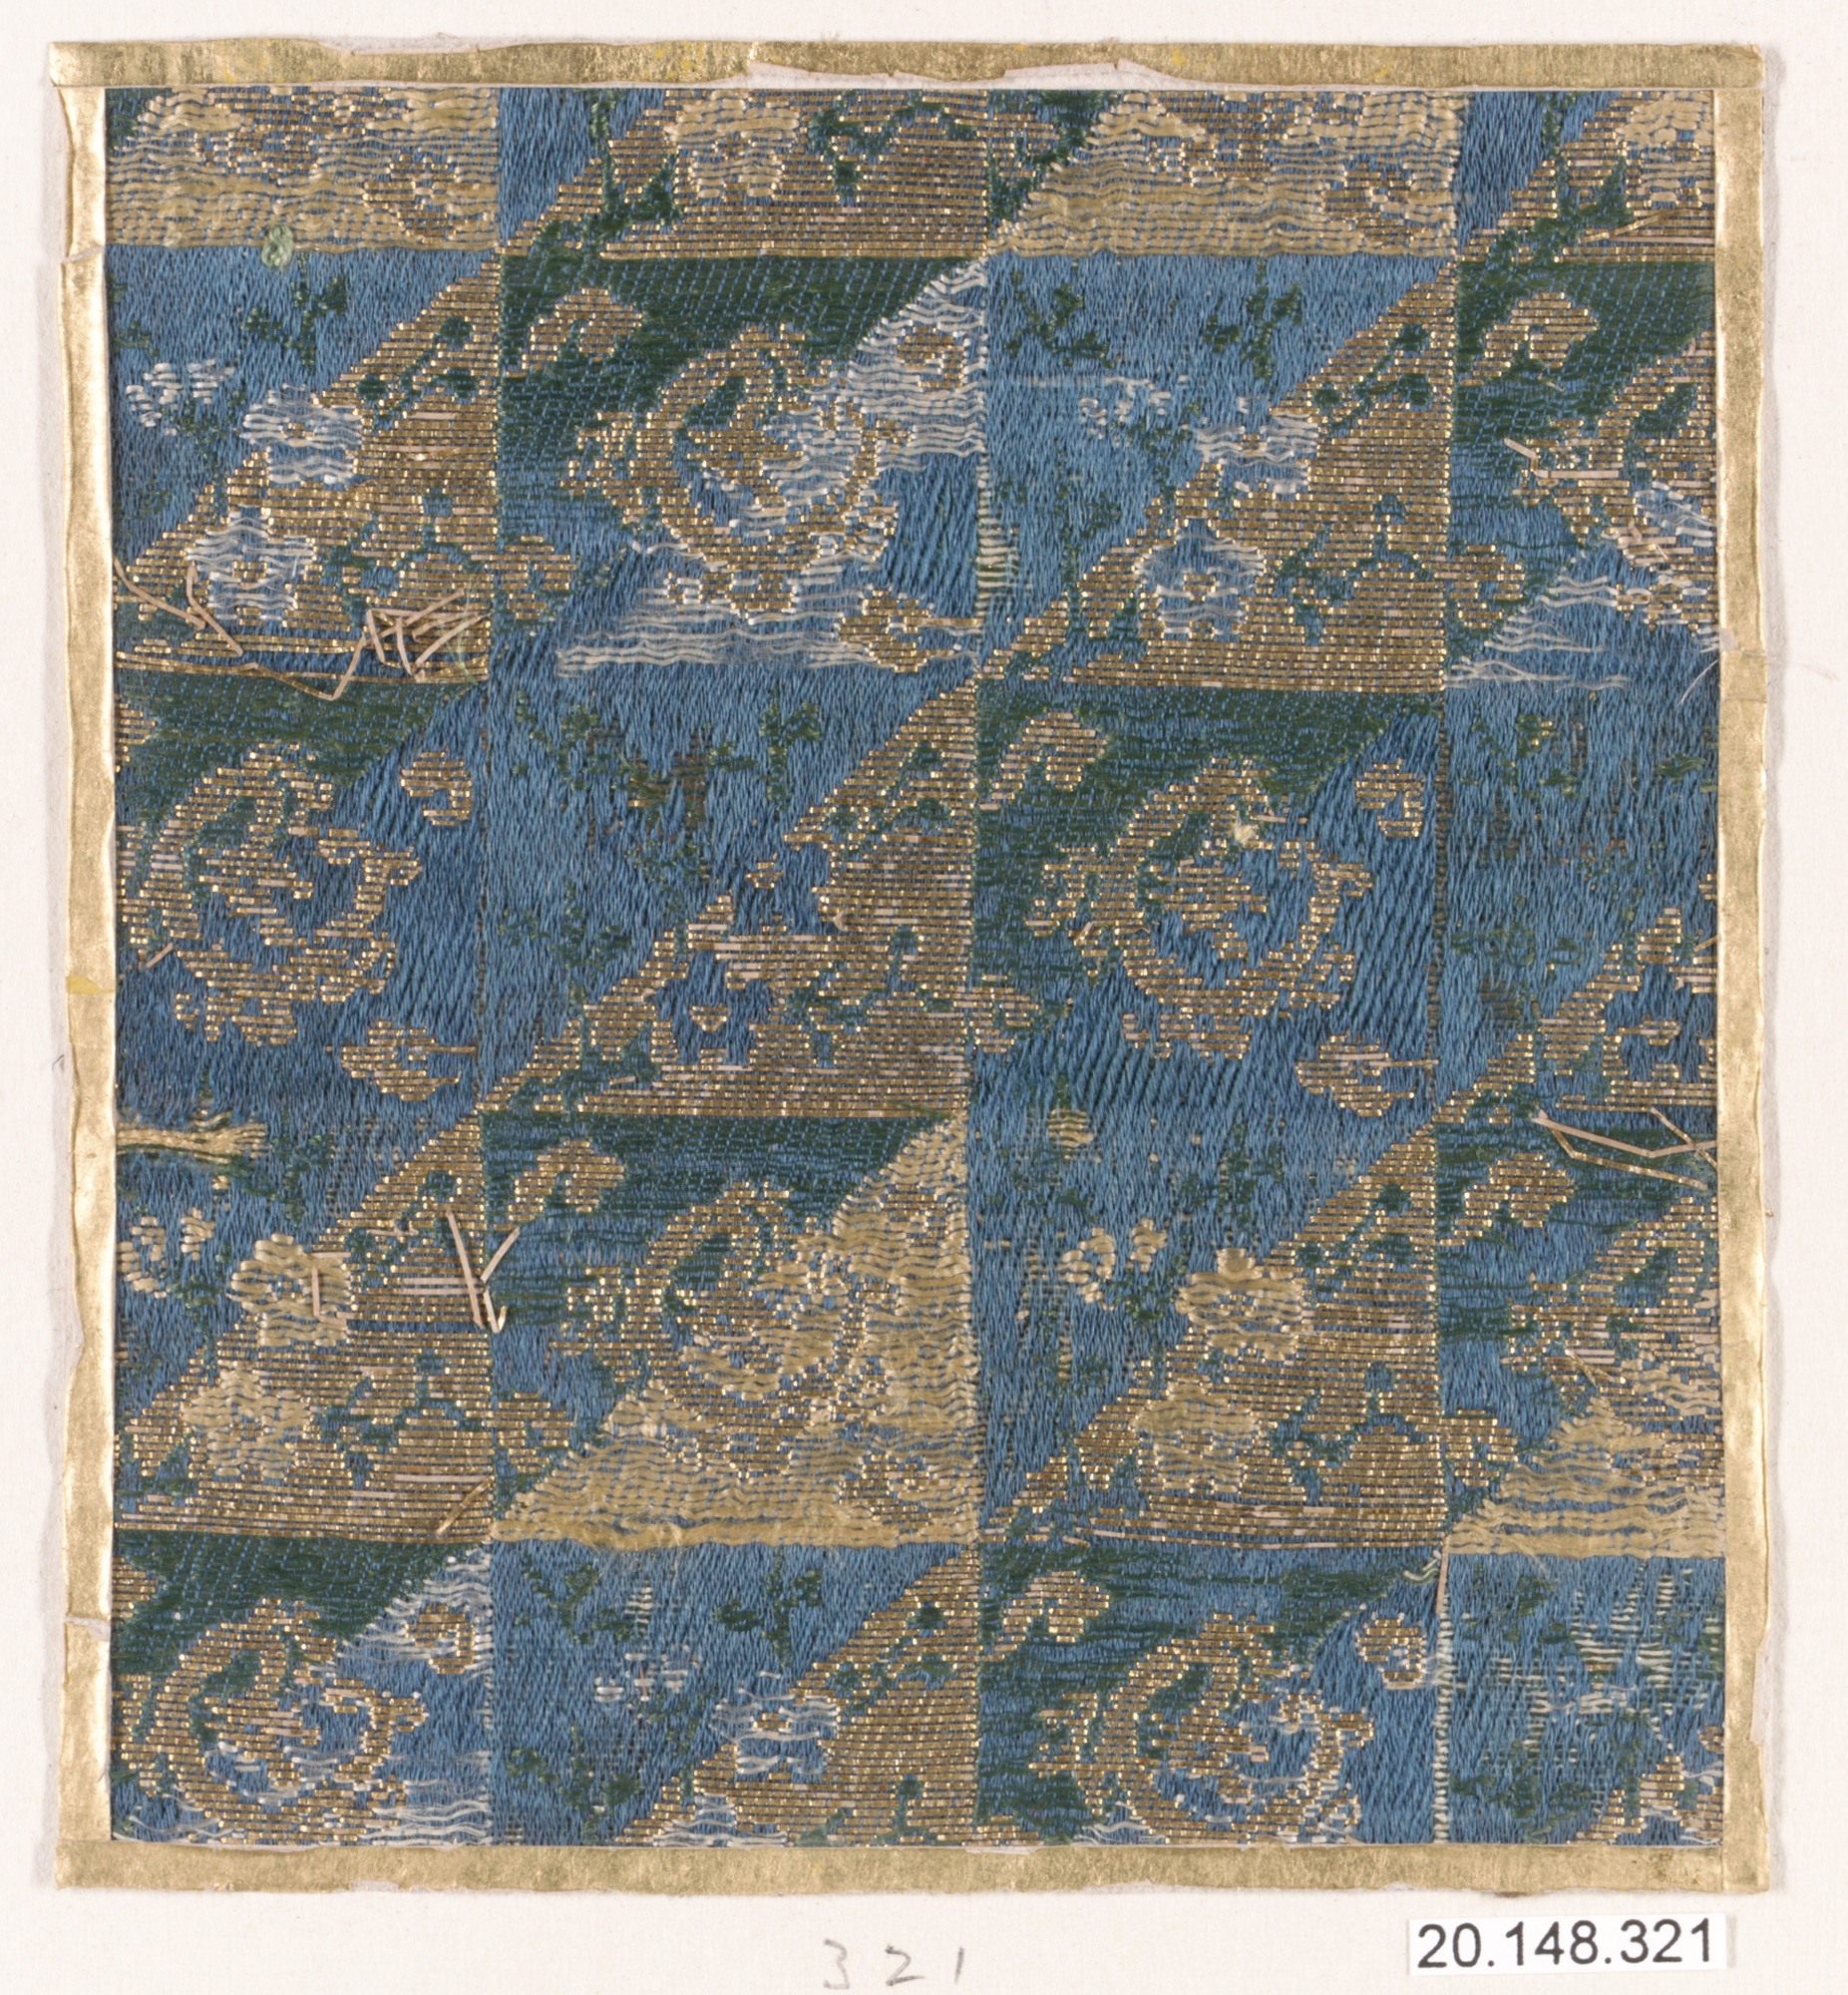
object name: piece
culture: japanese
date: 1601-1700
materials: silk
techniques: compound weave